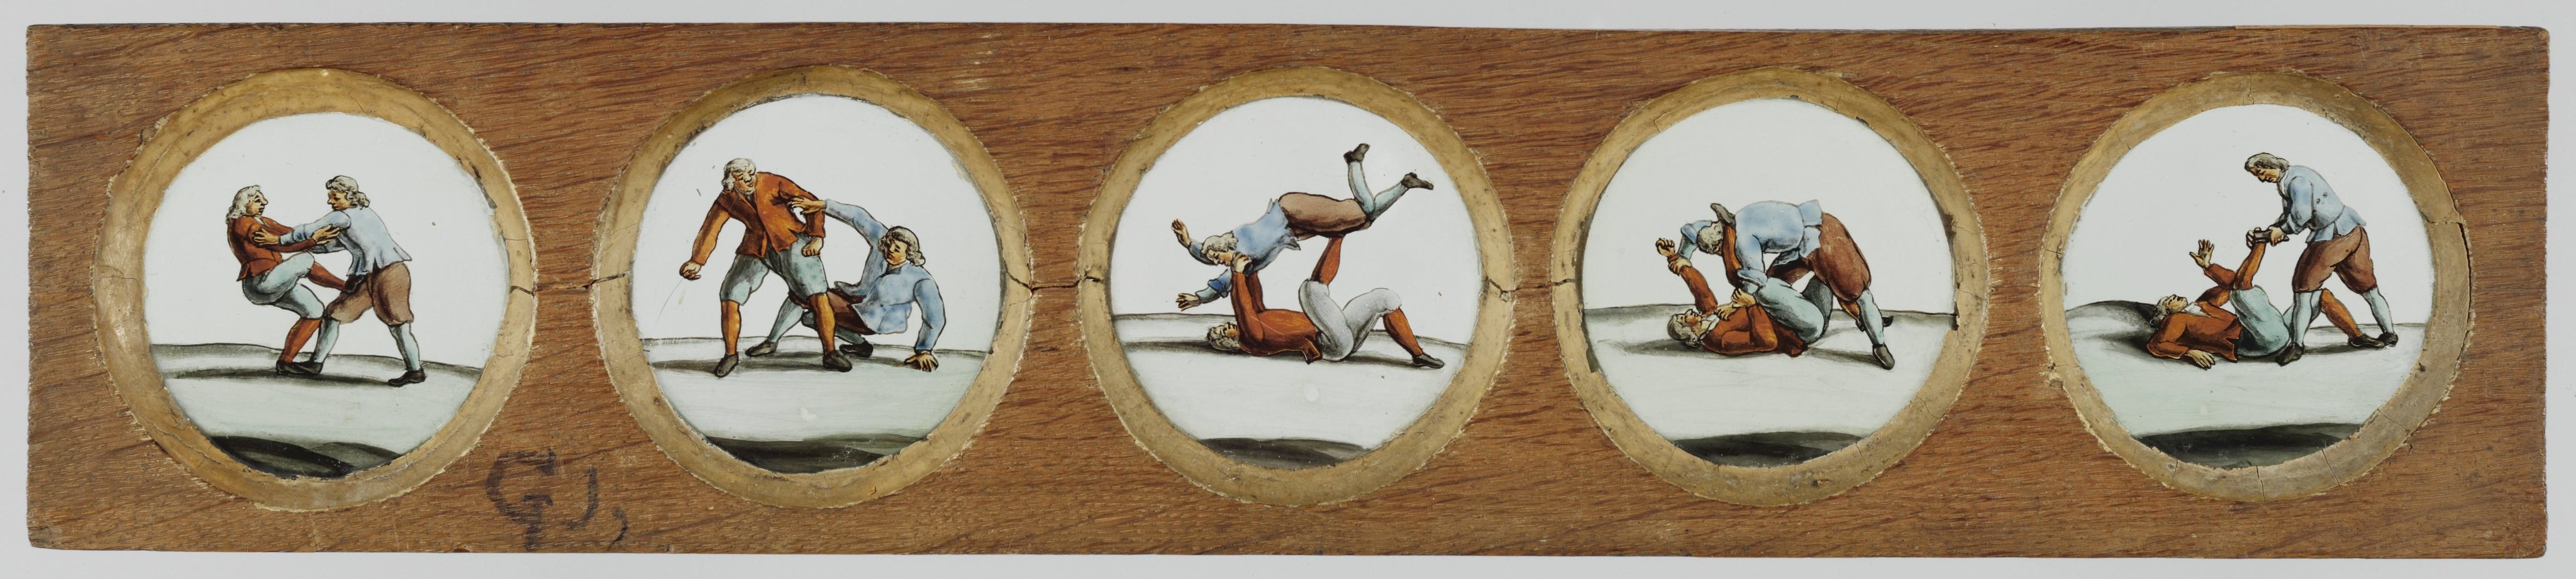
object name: lantern slide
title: Vijf afbeeldingen van twee worstelende mannen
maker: Anonymous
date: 1700-1790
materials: glass, wood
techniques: painted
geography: netherlands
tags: wrestling (sport)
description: Afgebeeld zijn telkens een man met een blauw shirt en een man met een rood shirt. links = de man met het rode shirt staat links, de man met het blauwe shirt staat rechts. 2e van links = de man met het blauwe shirt probeert de man met het rode shirt omver te schoppen. midden = beide mannen liggen op de grond. De man met het blauwe shirt vliegt door de lucht. 2e van rechts = de man met het blauwe shirt staat gebogen over de man met het rode shirt. Deze legt zijn been om de man met het blauwe shirt. rechts = de man met het rode shirt ligt op de grond. De man met het blauwe shirt verdraait zijn voet.